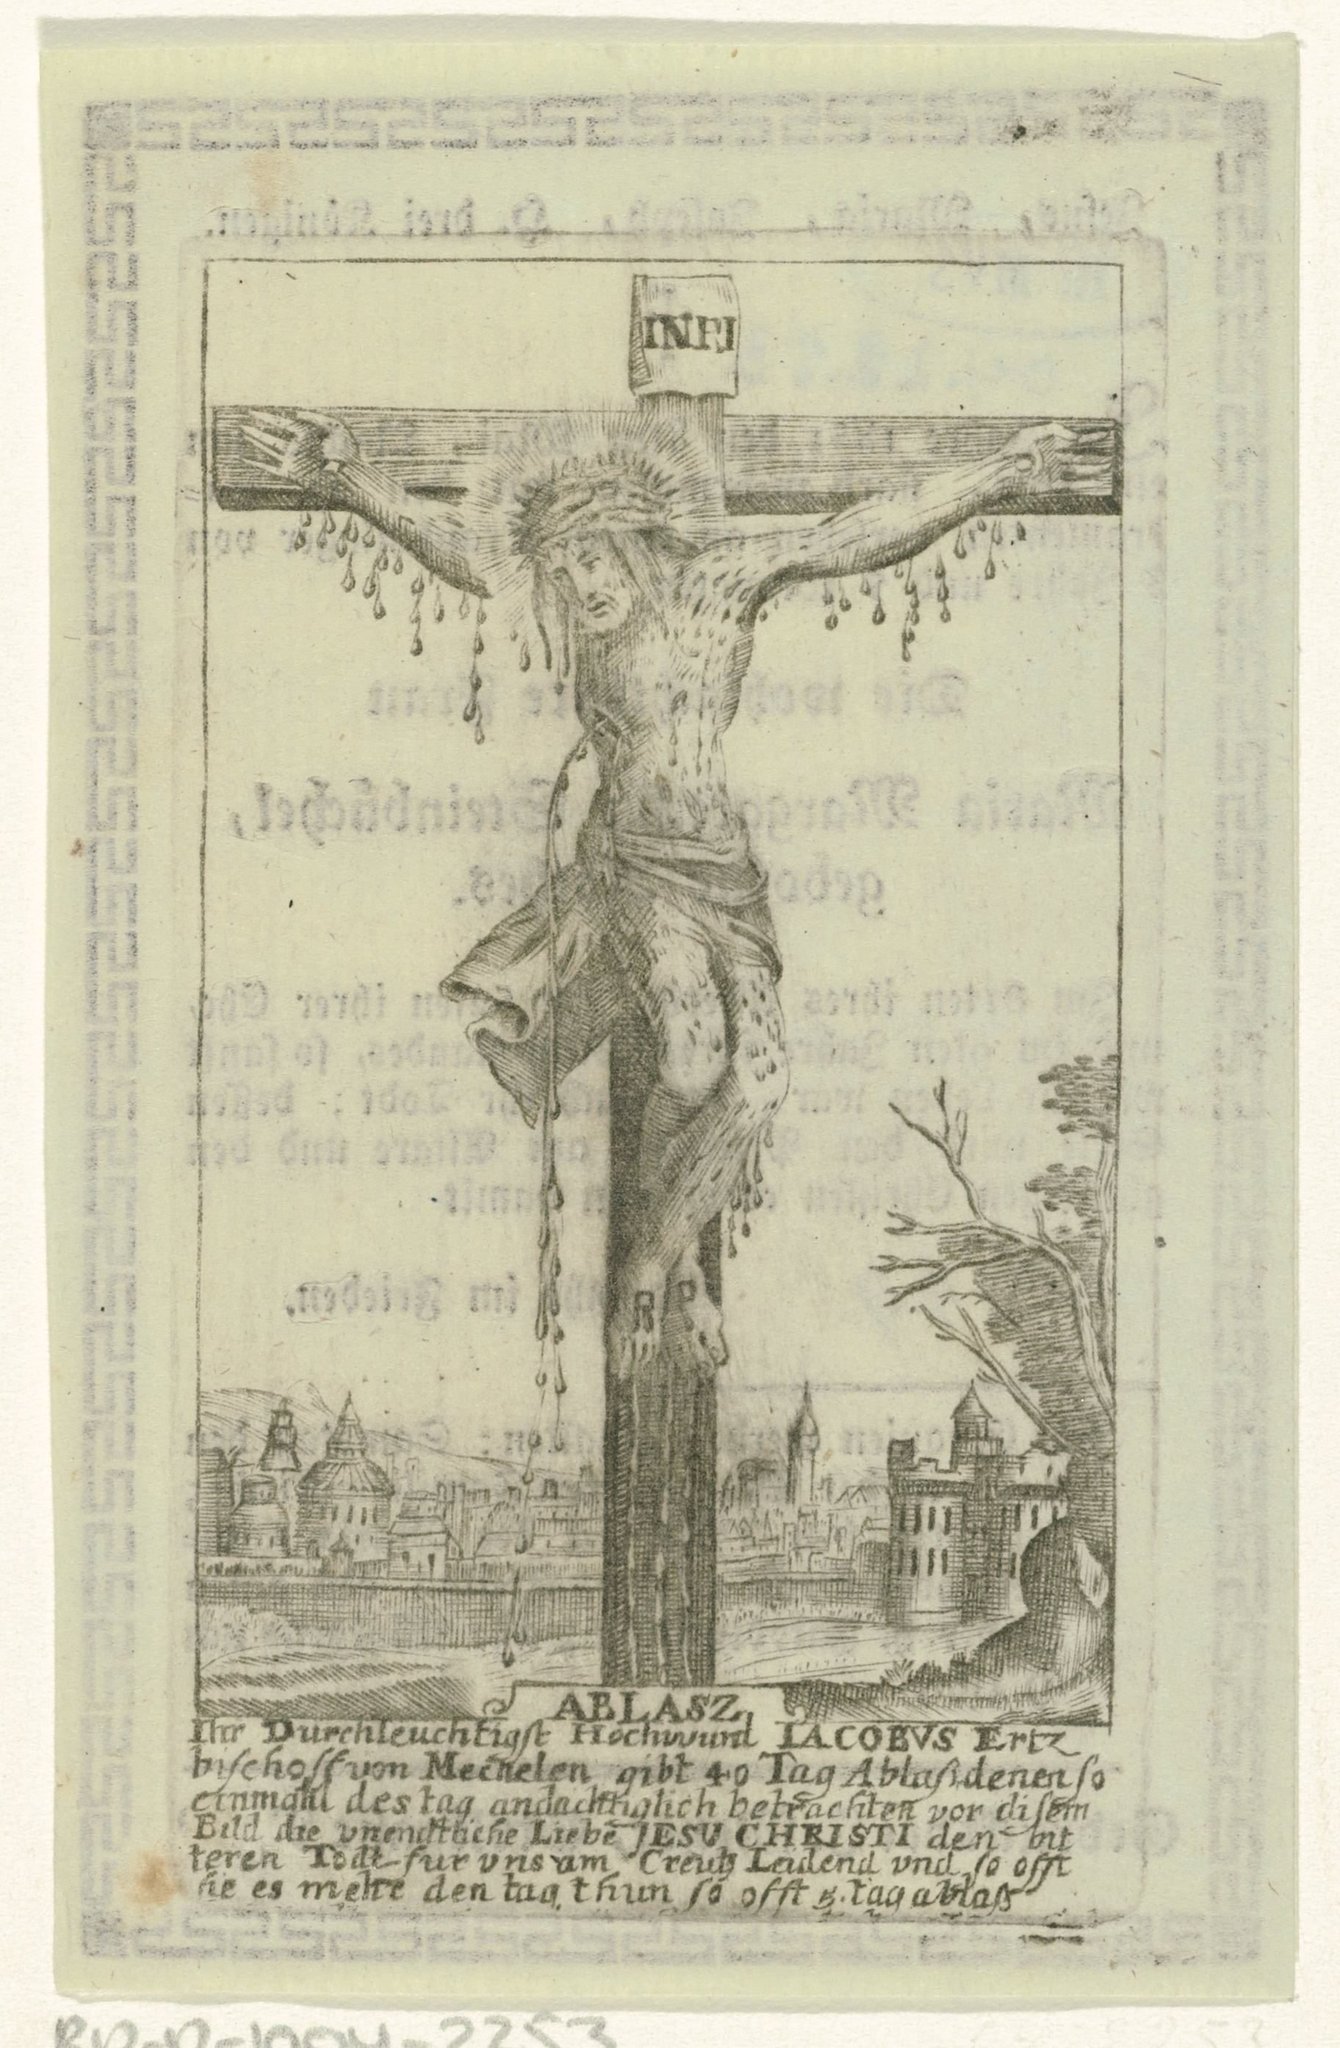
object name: print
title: Christus aan het kruis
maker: ch. cool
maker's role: print maker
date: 1600-1699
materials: paper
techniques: letterpress printing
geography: netherlands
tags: the crucifixion of christ: christ's death on the cross; golgotha (matthew 27:45-58; mark 15:33-45; luke 23:44-52; john 19:25-38)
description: Christus aan het kruis genageld, het bloed stroomt op verschillende plaatsen uit zijn lichaam. Op de achtergrond de stad Jeruzalem. In de ondermarge zeven regels Duitse tekst. Aflaat van aartsbisschop Jacob van Mechelen.